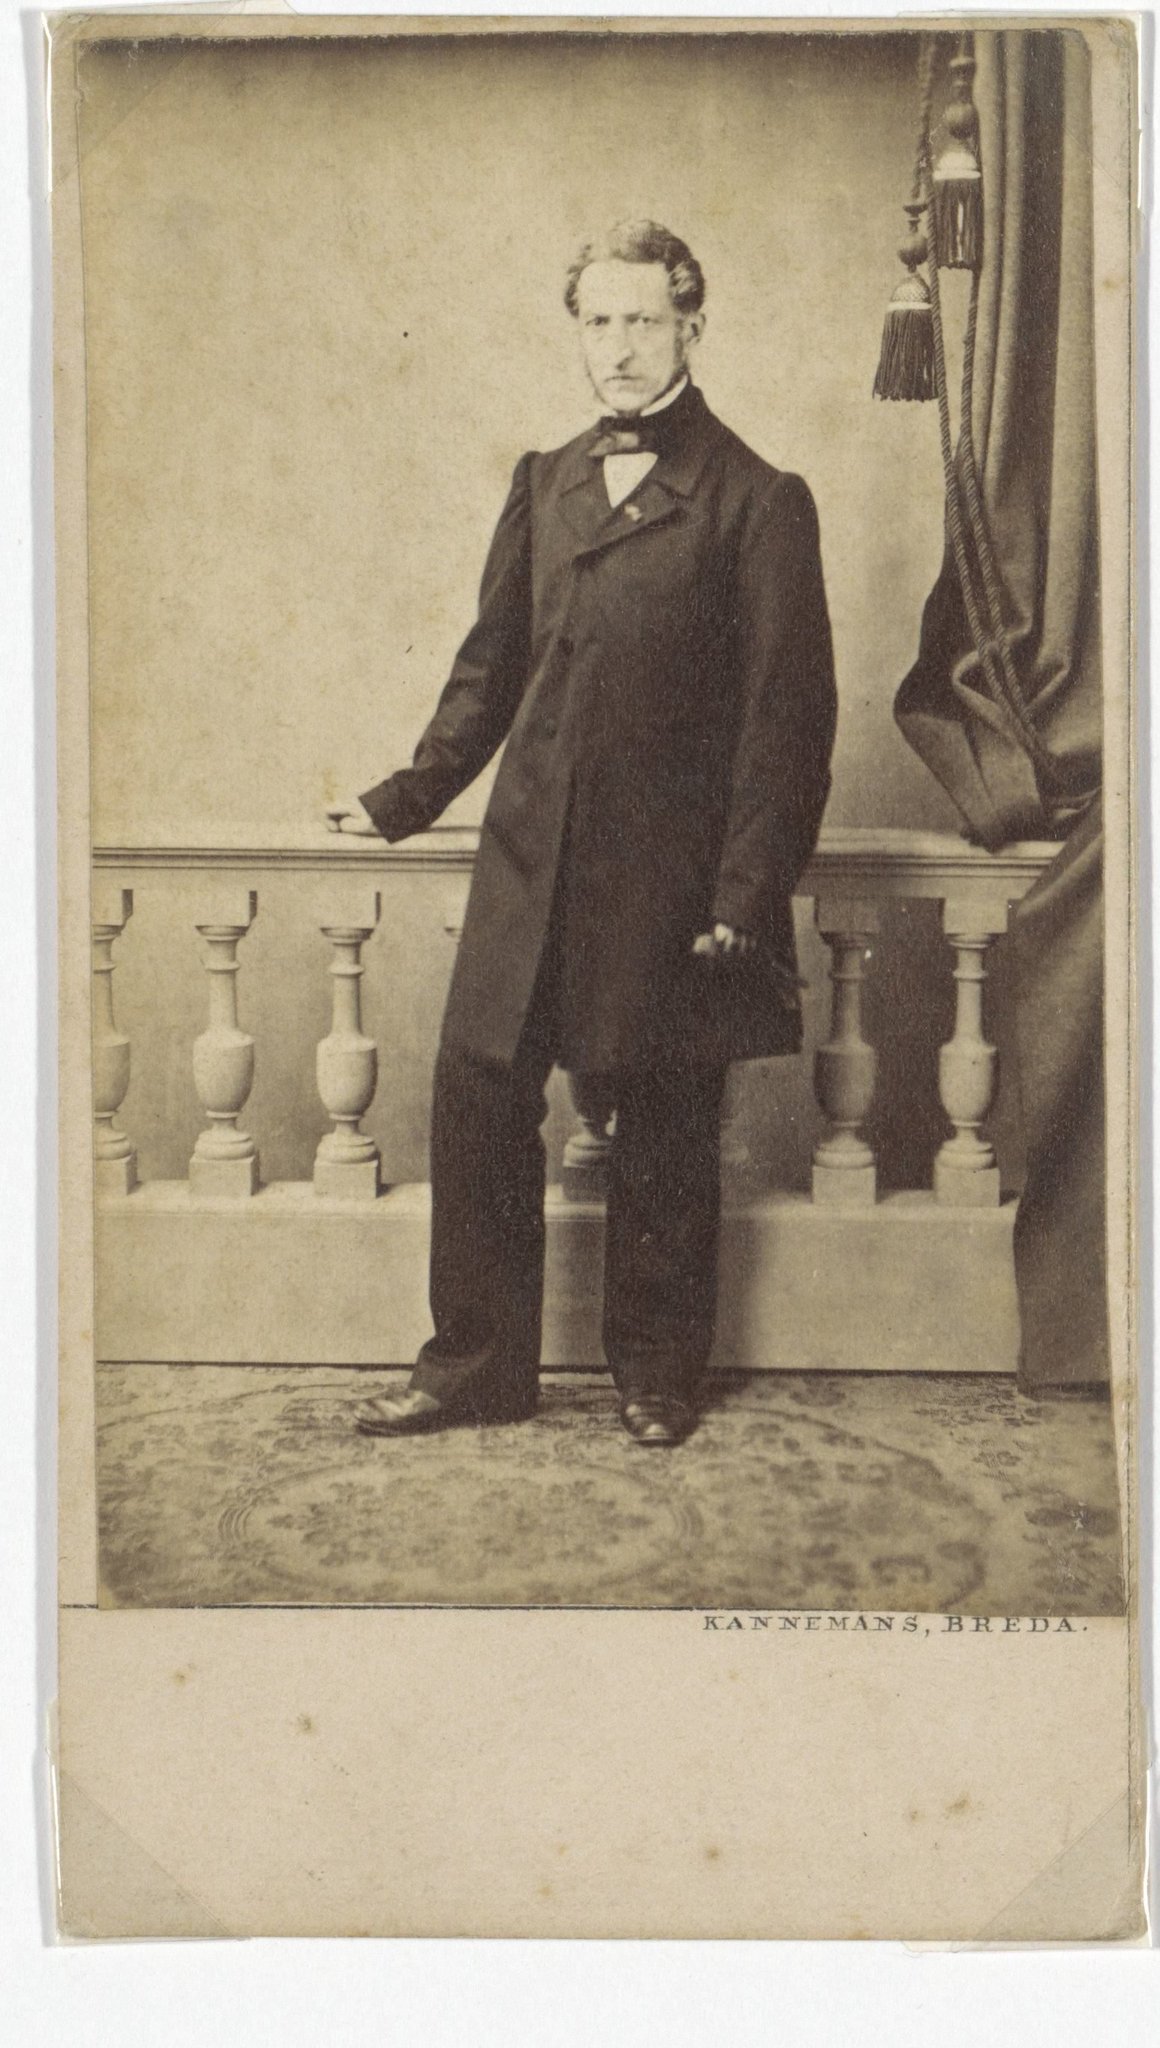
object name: carte de visite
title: Portret van professor A.A. van Heusden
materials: cardboard, paper, photographic support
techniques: albumen print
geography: breda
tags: studio requisites ~ photographer, historical persons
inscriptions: inscription: ‘Prof. Dr. van Heusden Hoogleeraar Mil. Academie Ridder inde Orde v.d. Nederl Leeuw grootvader van Appie van Heusden’